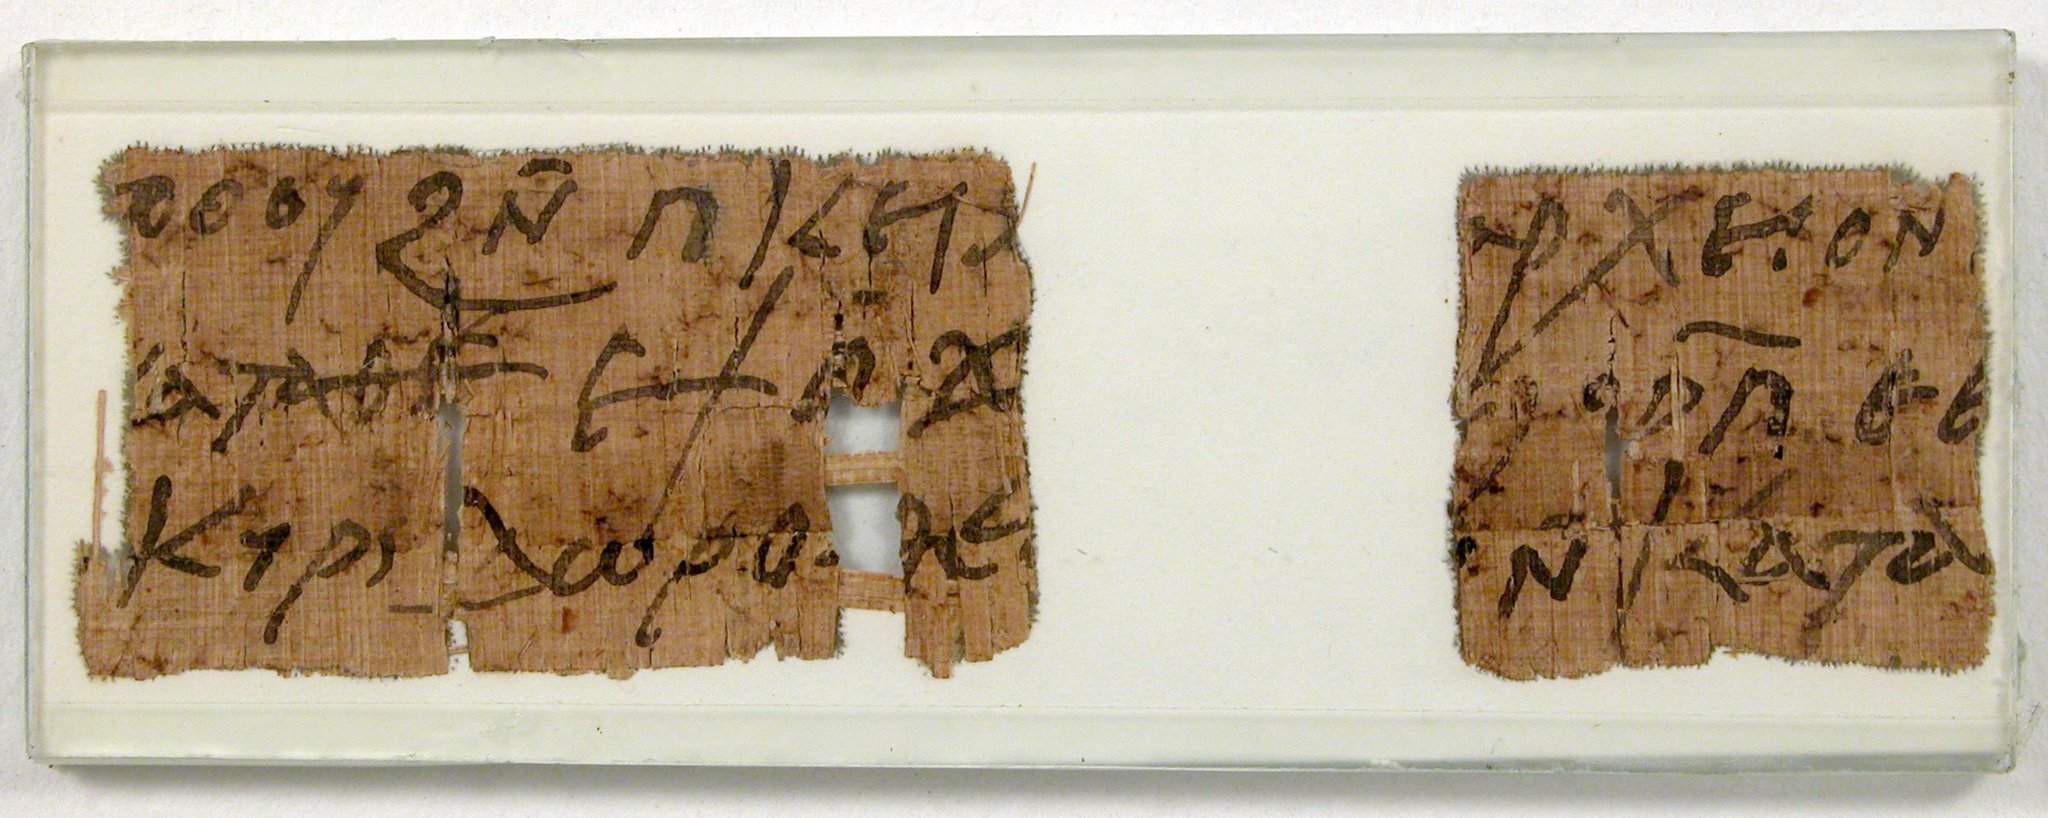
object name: fragment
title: Papyri Fragments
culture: coptic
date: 601-700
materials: ink, papyrus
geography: egypt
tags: coptic,documents